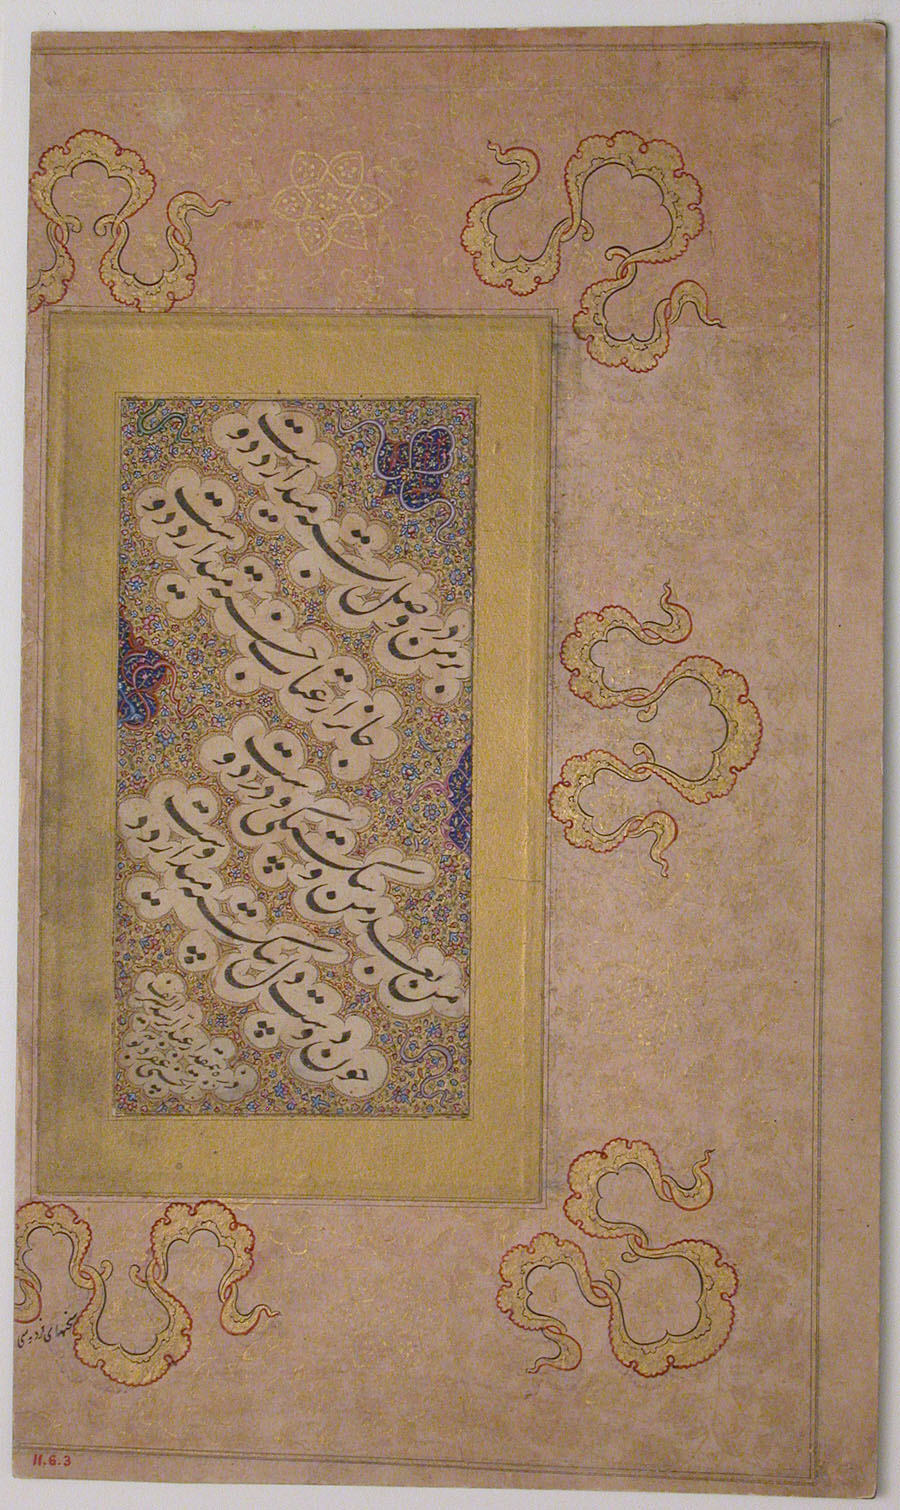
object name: non illustrated album leaf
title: Page of Calligraphy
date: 1601-1700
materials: gold, ink, paper, watercolor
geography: iran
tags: persian